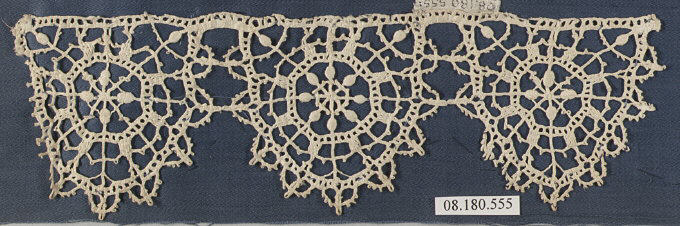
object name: fragment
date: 1601-1700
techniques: lace